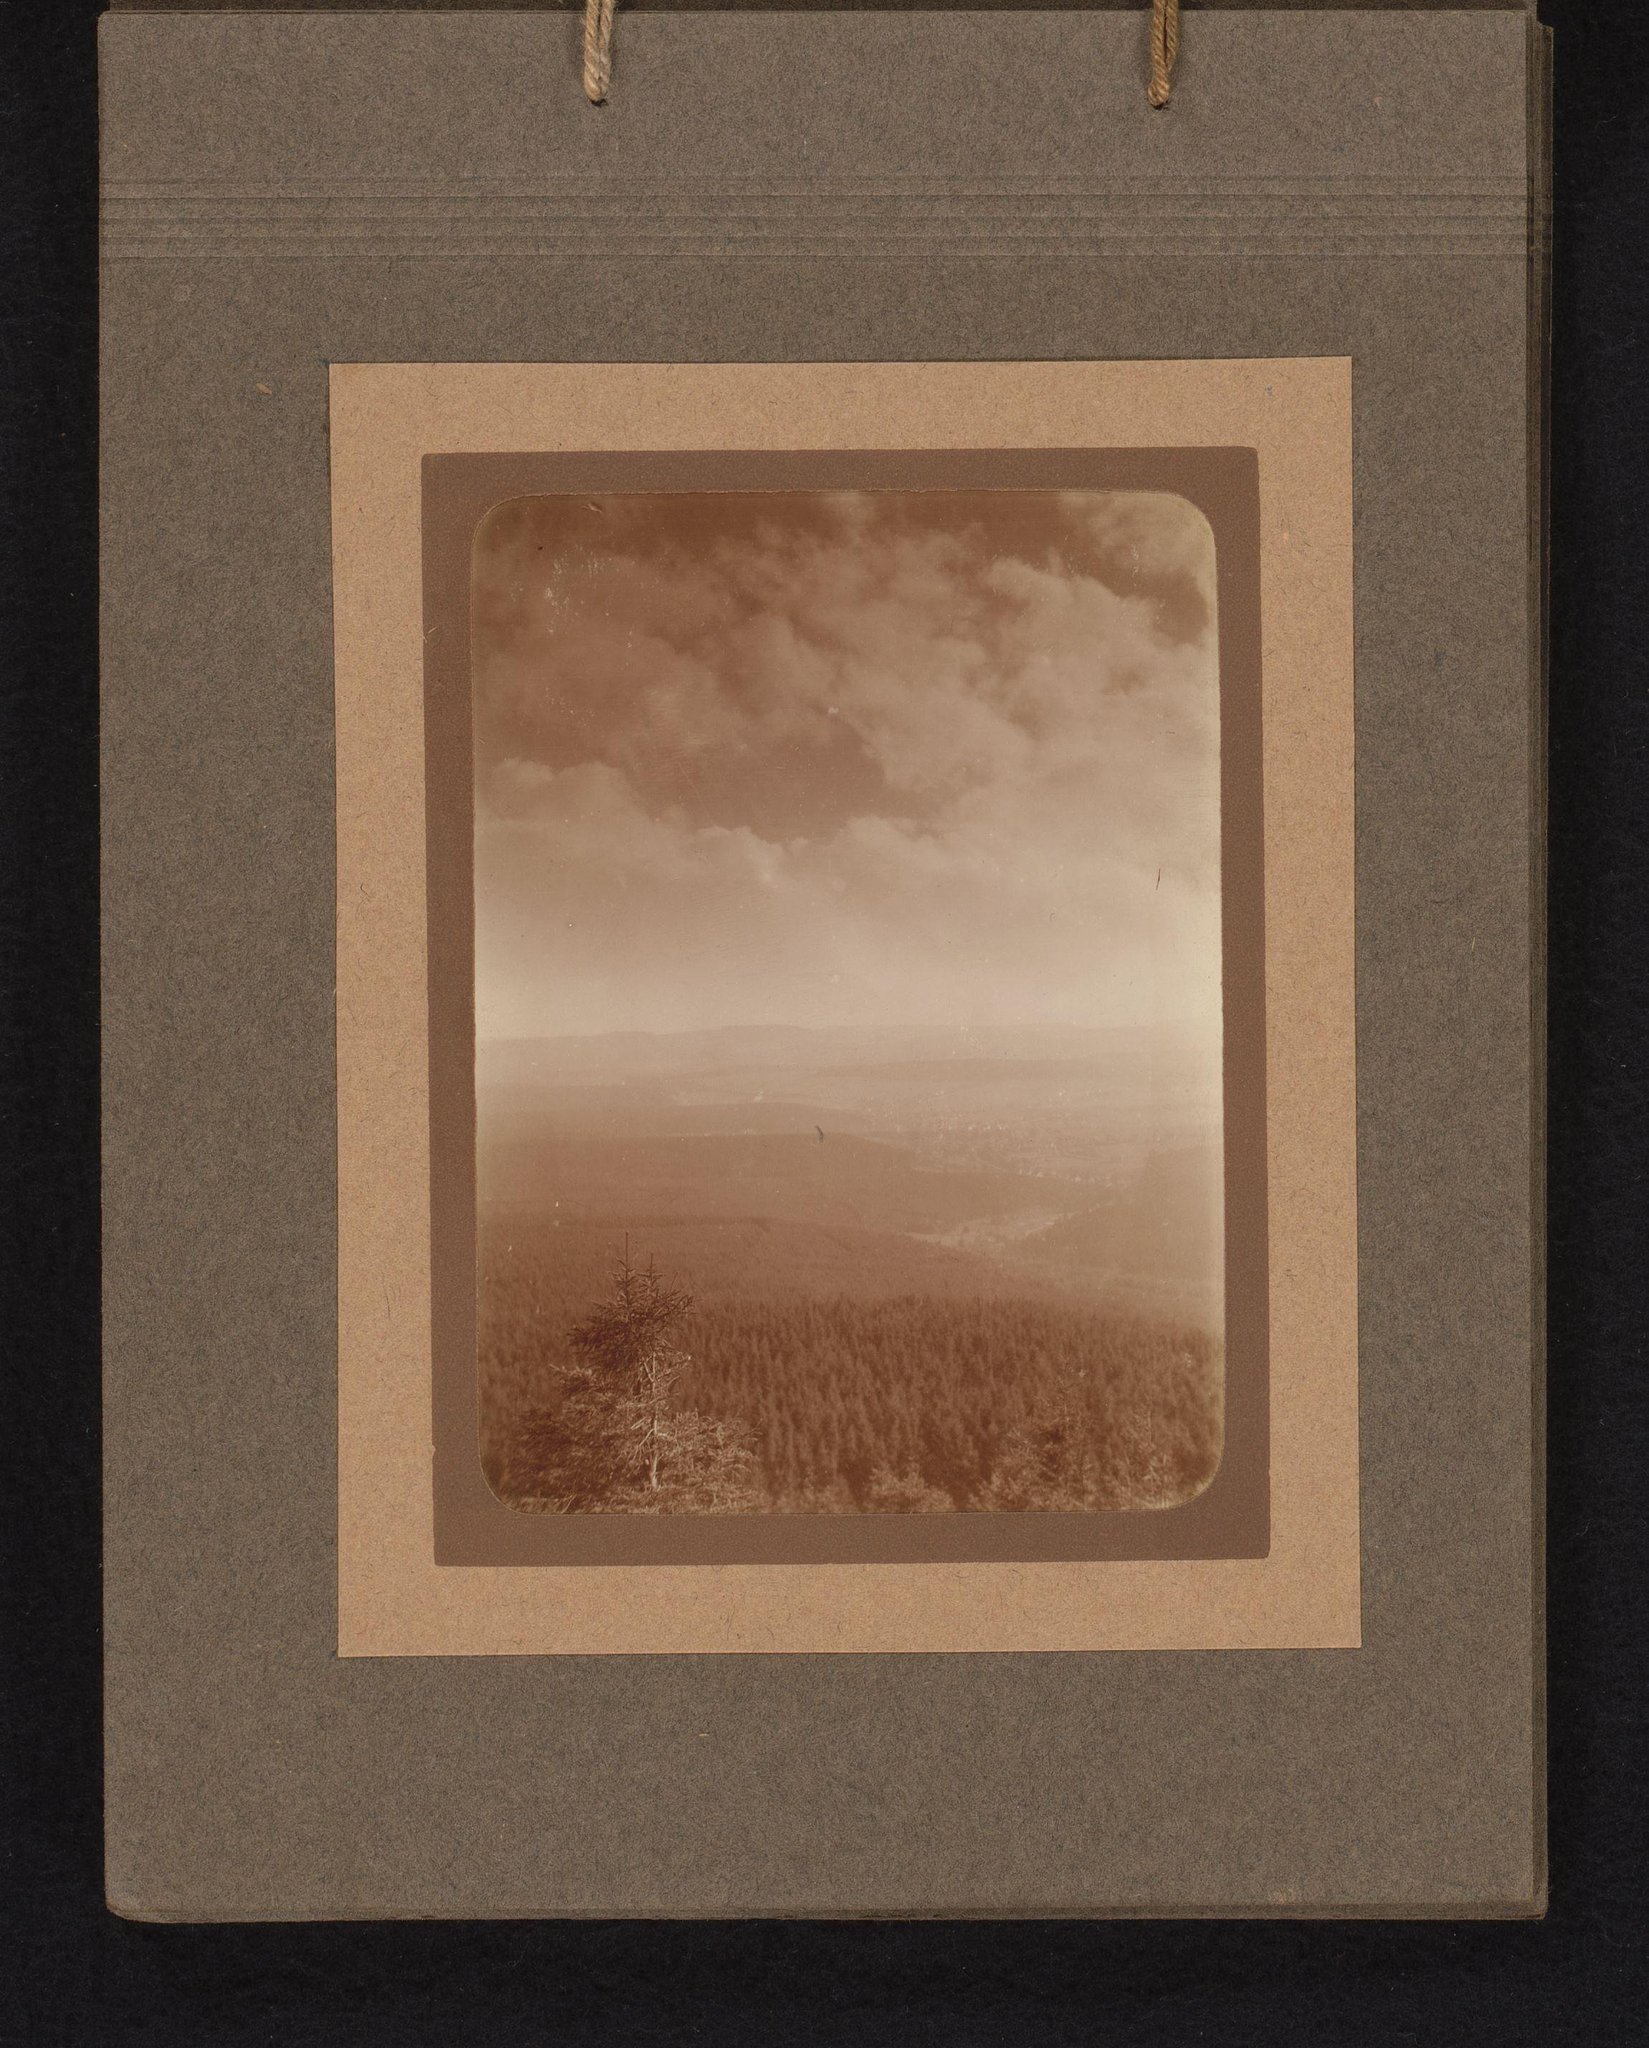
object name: photograph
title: Uitzicht over een bos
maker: Anonymous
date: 1880-1930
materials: cardboard, photographic support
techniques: collodion silver print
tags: clouds, forest, wood